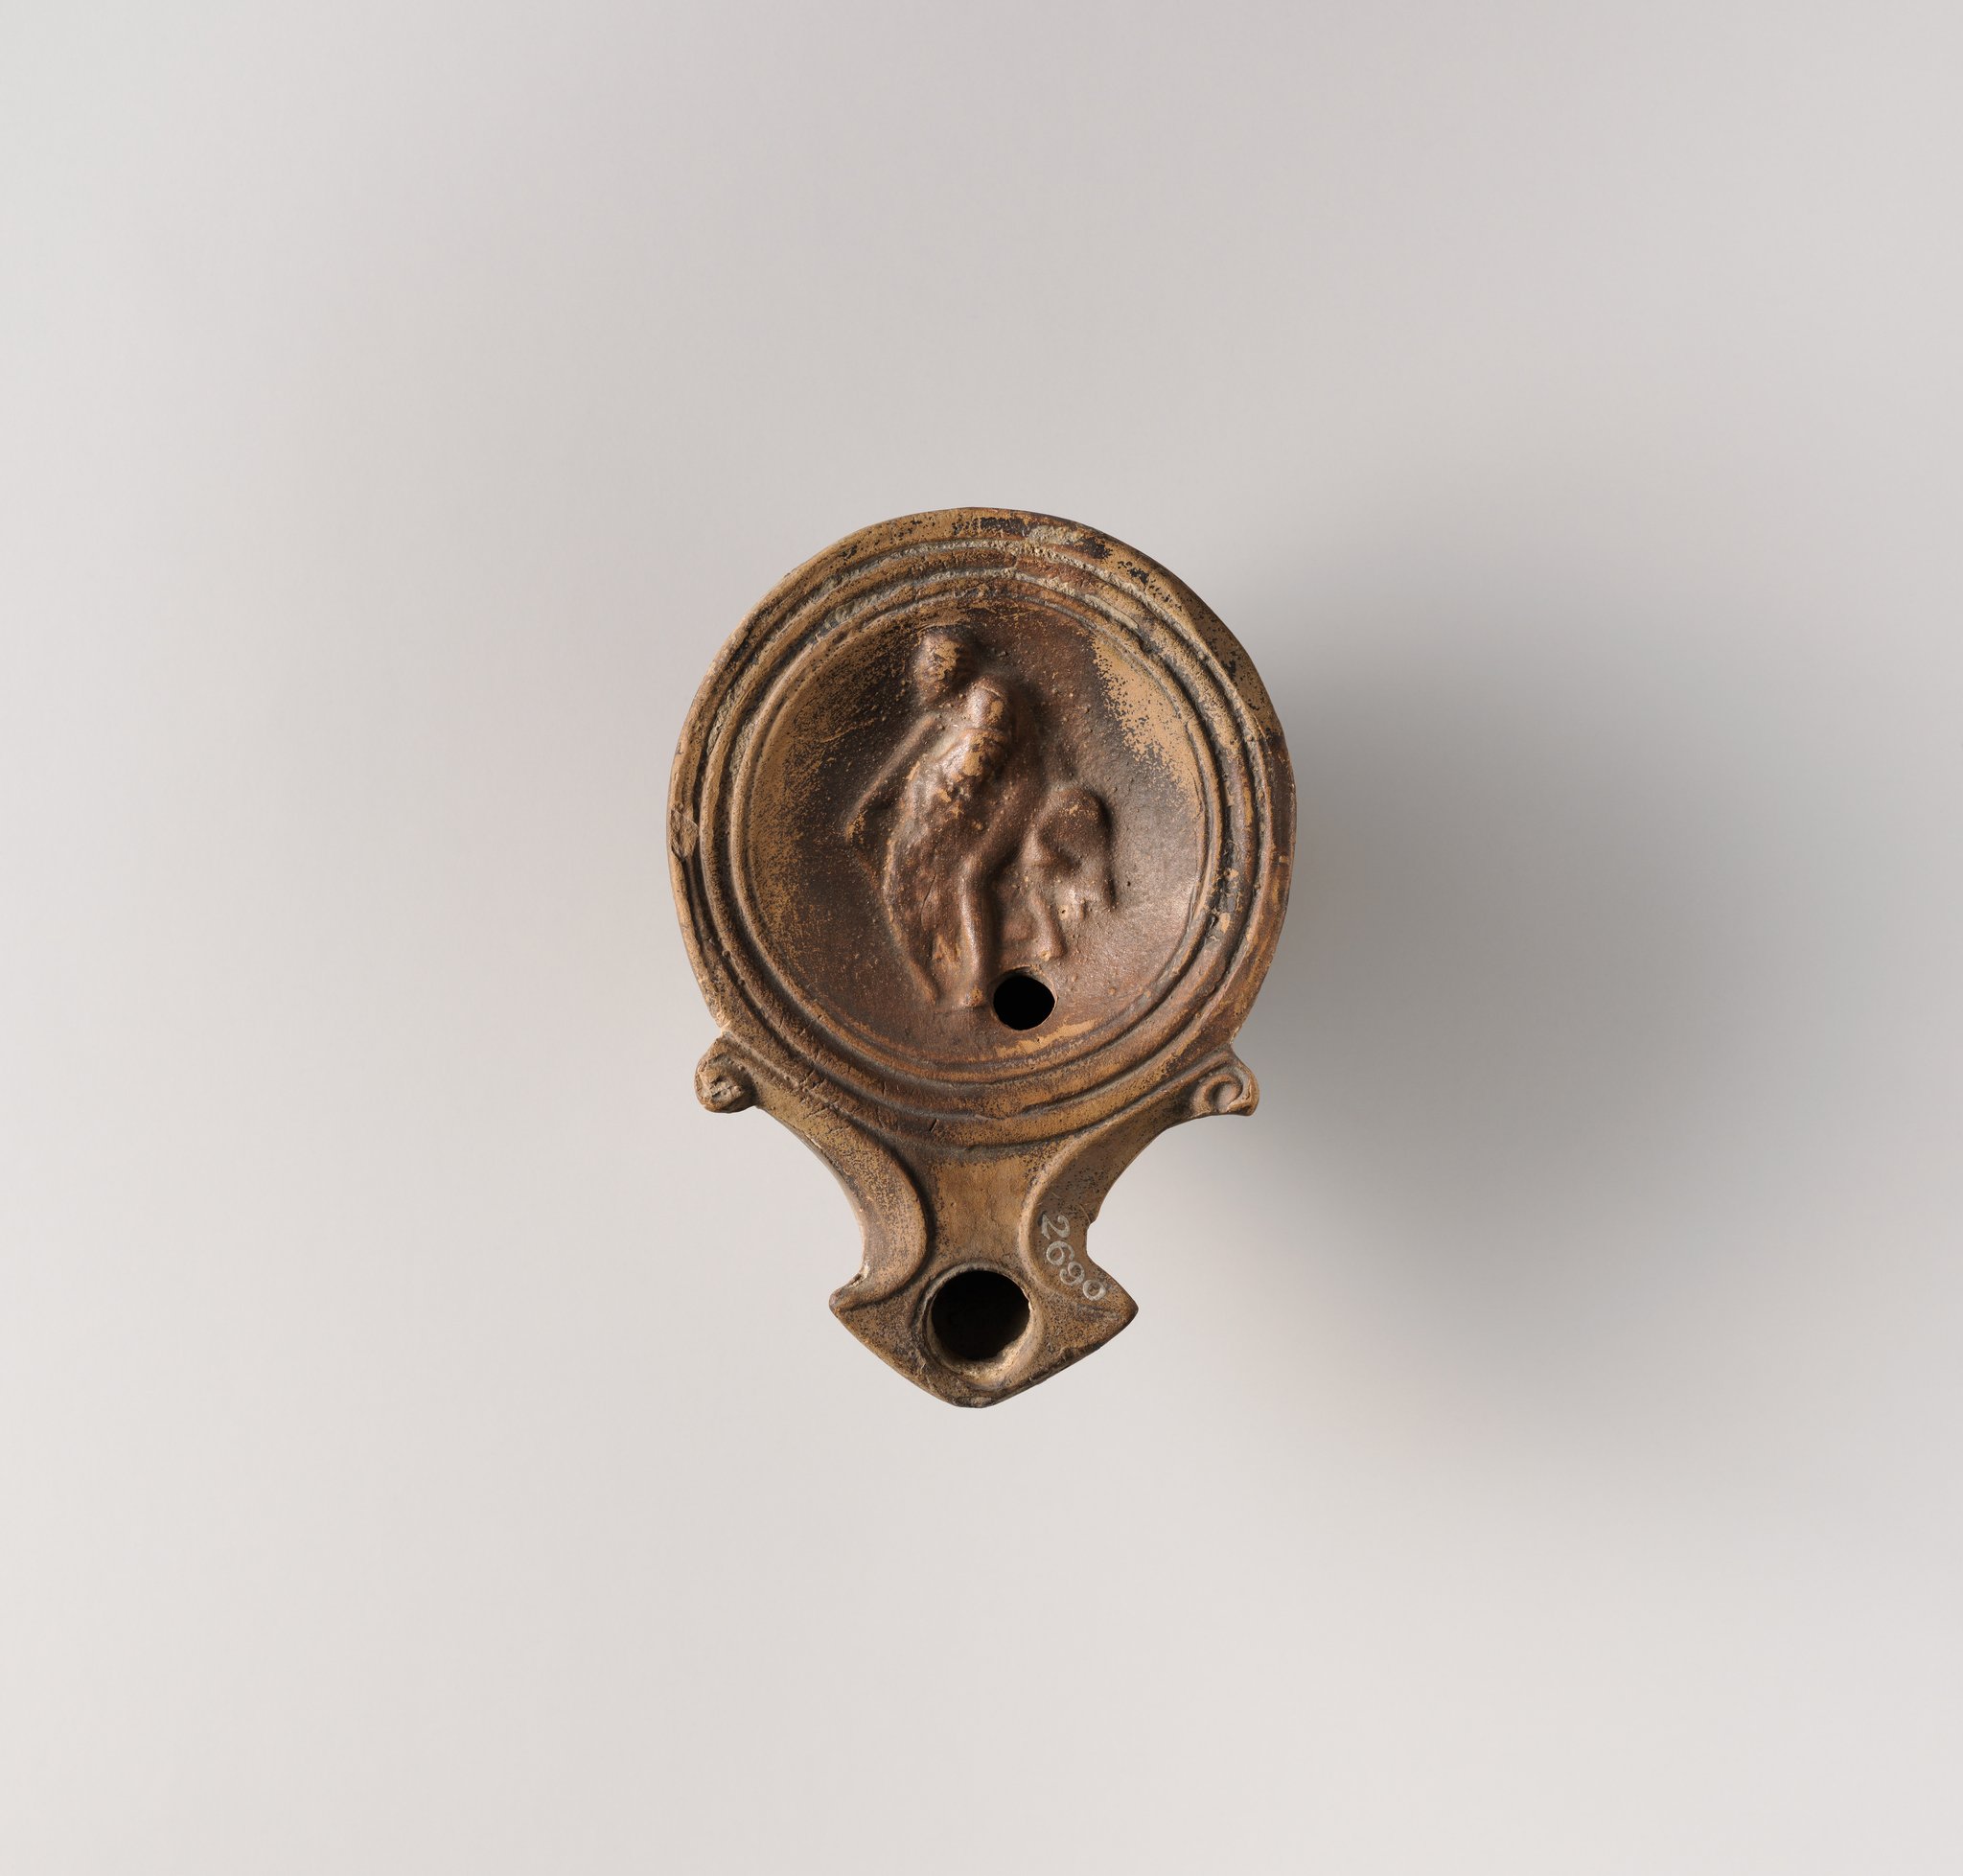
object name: lamp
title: Terracotta oil lamp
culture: roman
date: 1-100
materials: terracotta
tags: centaurs